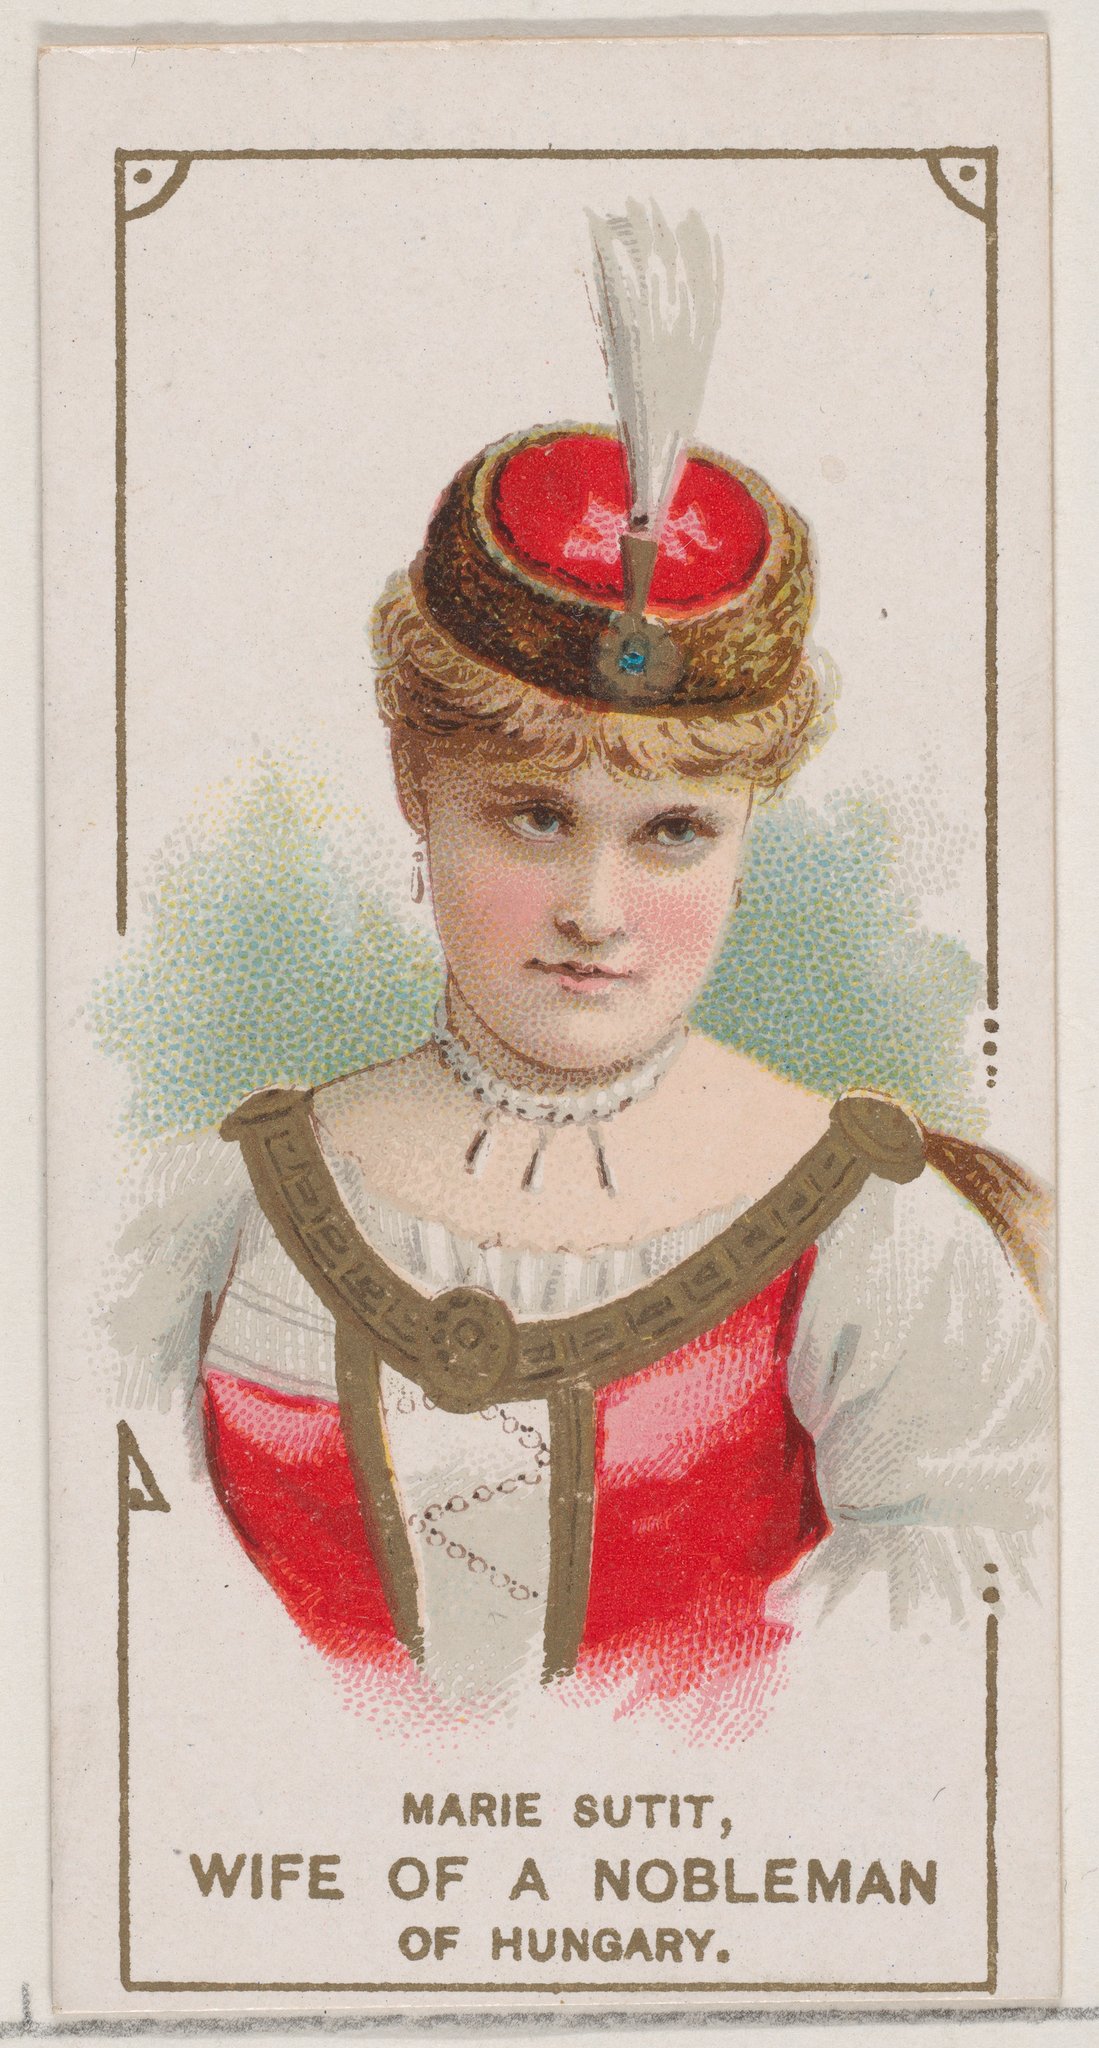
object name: print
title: Marie Sutit as the Wife of a Nobleman of Hungary, from the set Actors and Actresses, Second Series (N71) for Duke brand cigarettes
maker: w. duke, sons & co.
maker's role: publisher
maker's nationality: american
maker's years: 1870-1920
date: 1888-1890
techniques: color lithograph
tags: women,actresses